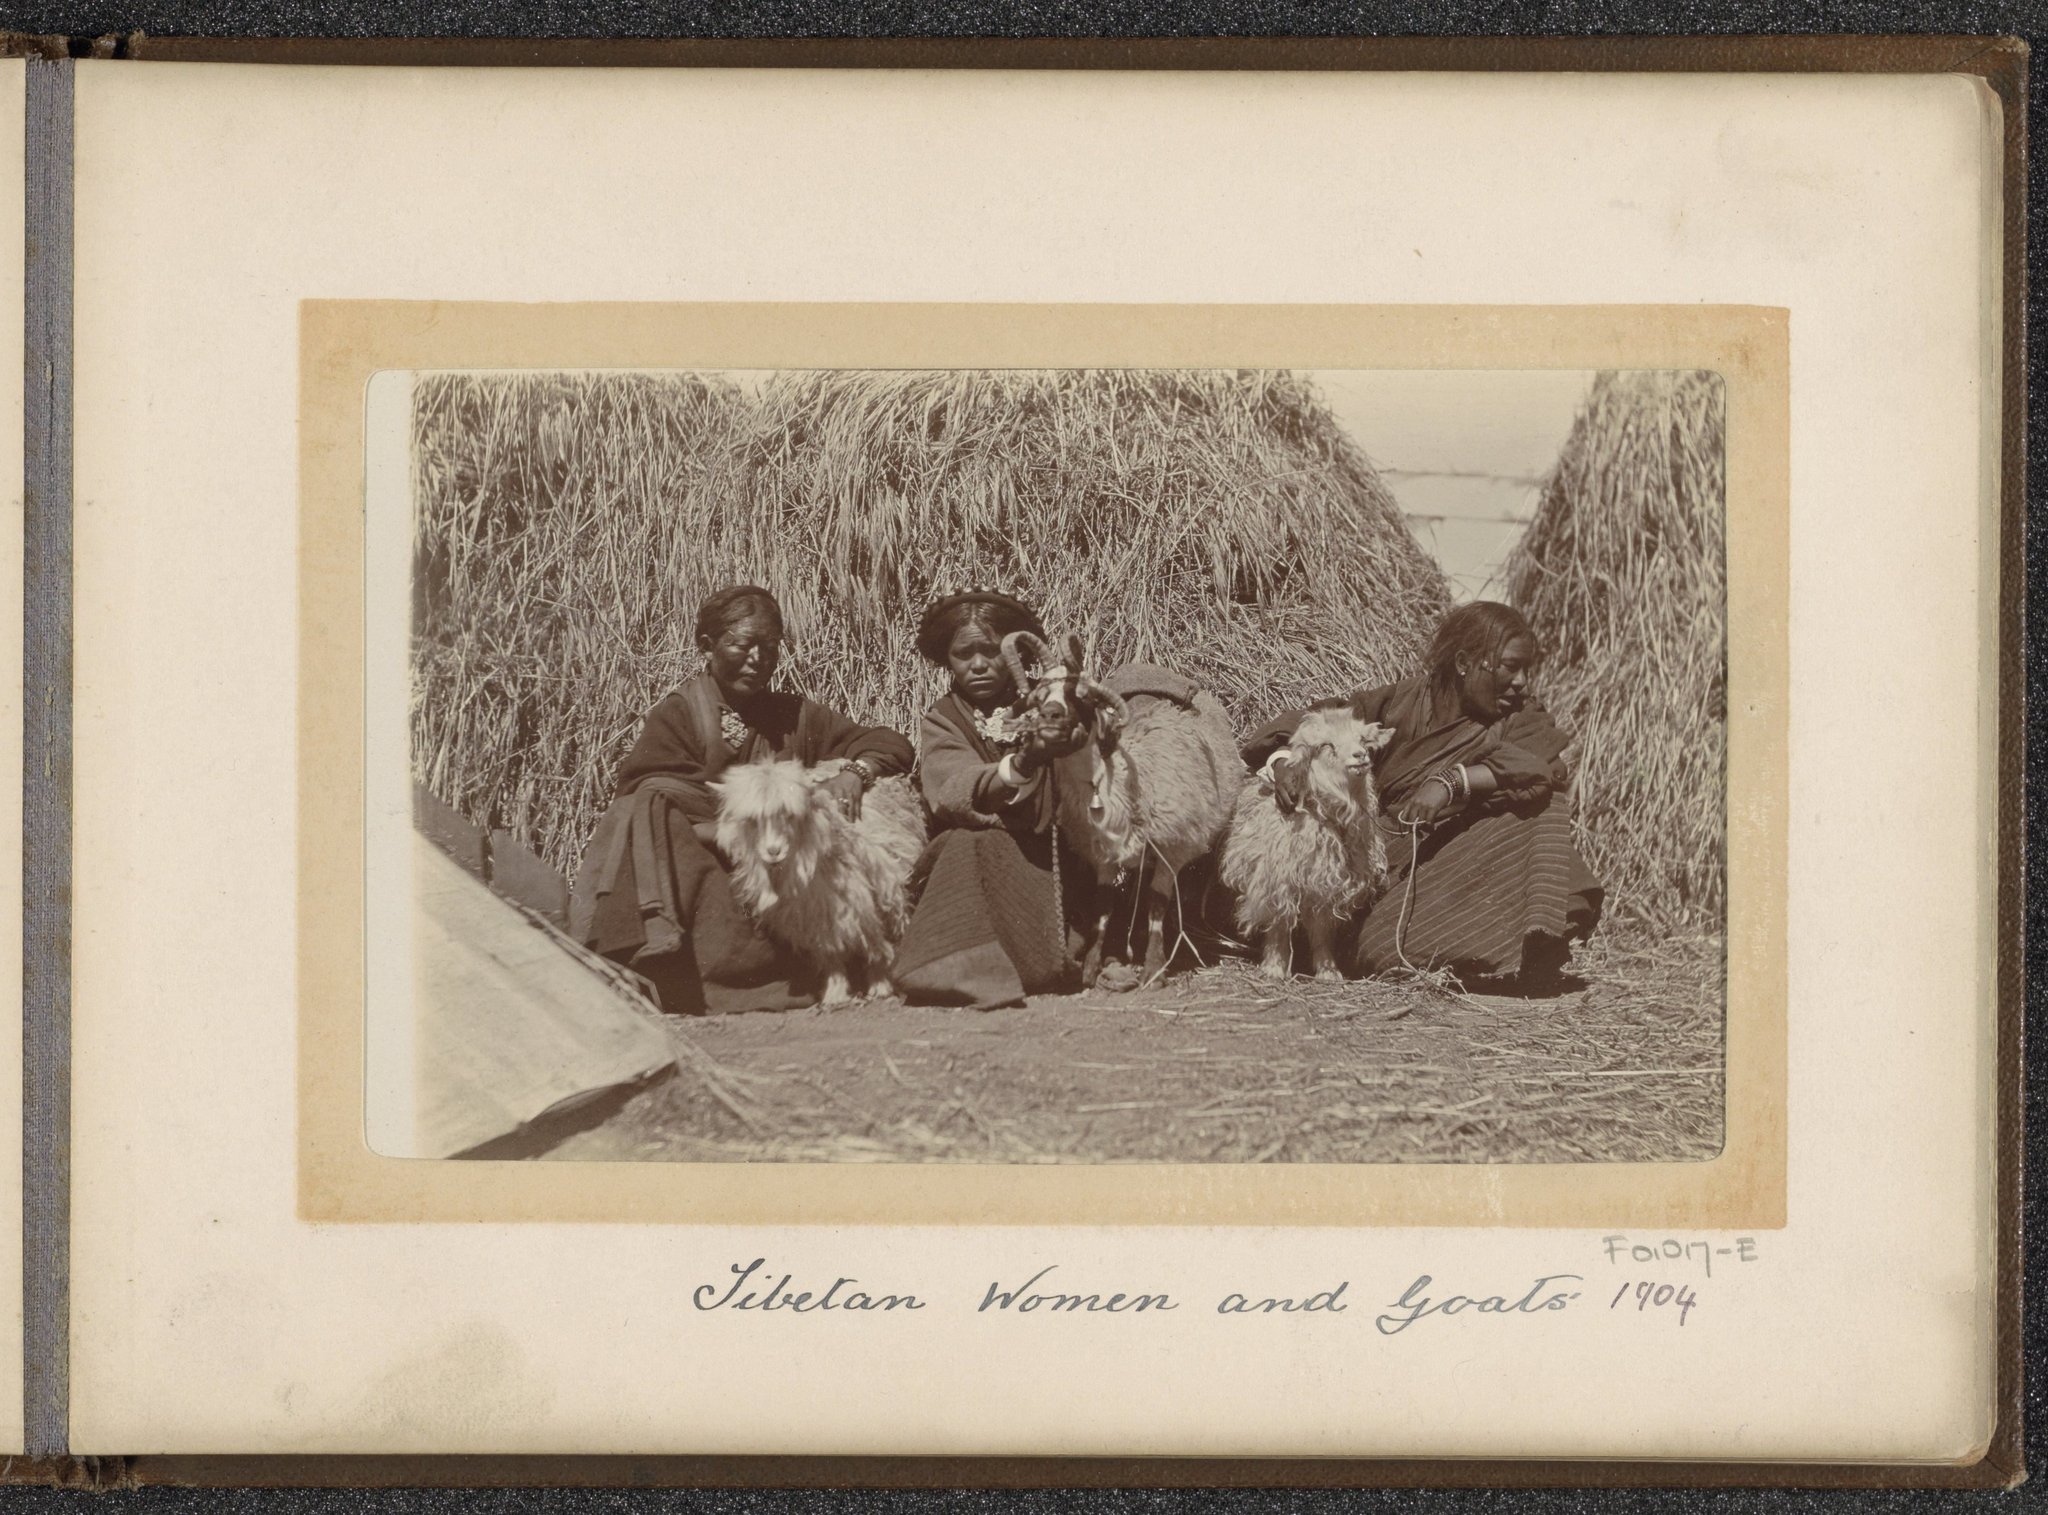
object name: photograph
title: Tibetan women with goats for haystacks, Tibet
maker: d.t. dalton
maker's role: sergeant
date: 1904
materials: photographic support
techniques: gelatin silver print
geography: tibet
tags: head-gear, styles of hairdress - aa - ~ women, clothes covering the entire body, hay-stack, goat, anonymous historical person portrayed - bb - woman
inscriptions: title: ‘Tibetan Women and Goats 1904’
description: Onderdeel van Fotoalbum met 24 foto's van de reis van legertelegrafist D.T. Dalton door Tibet.